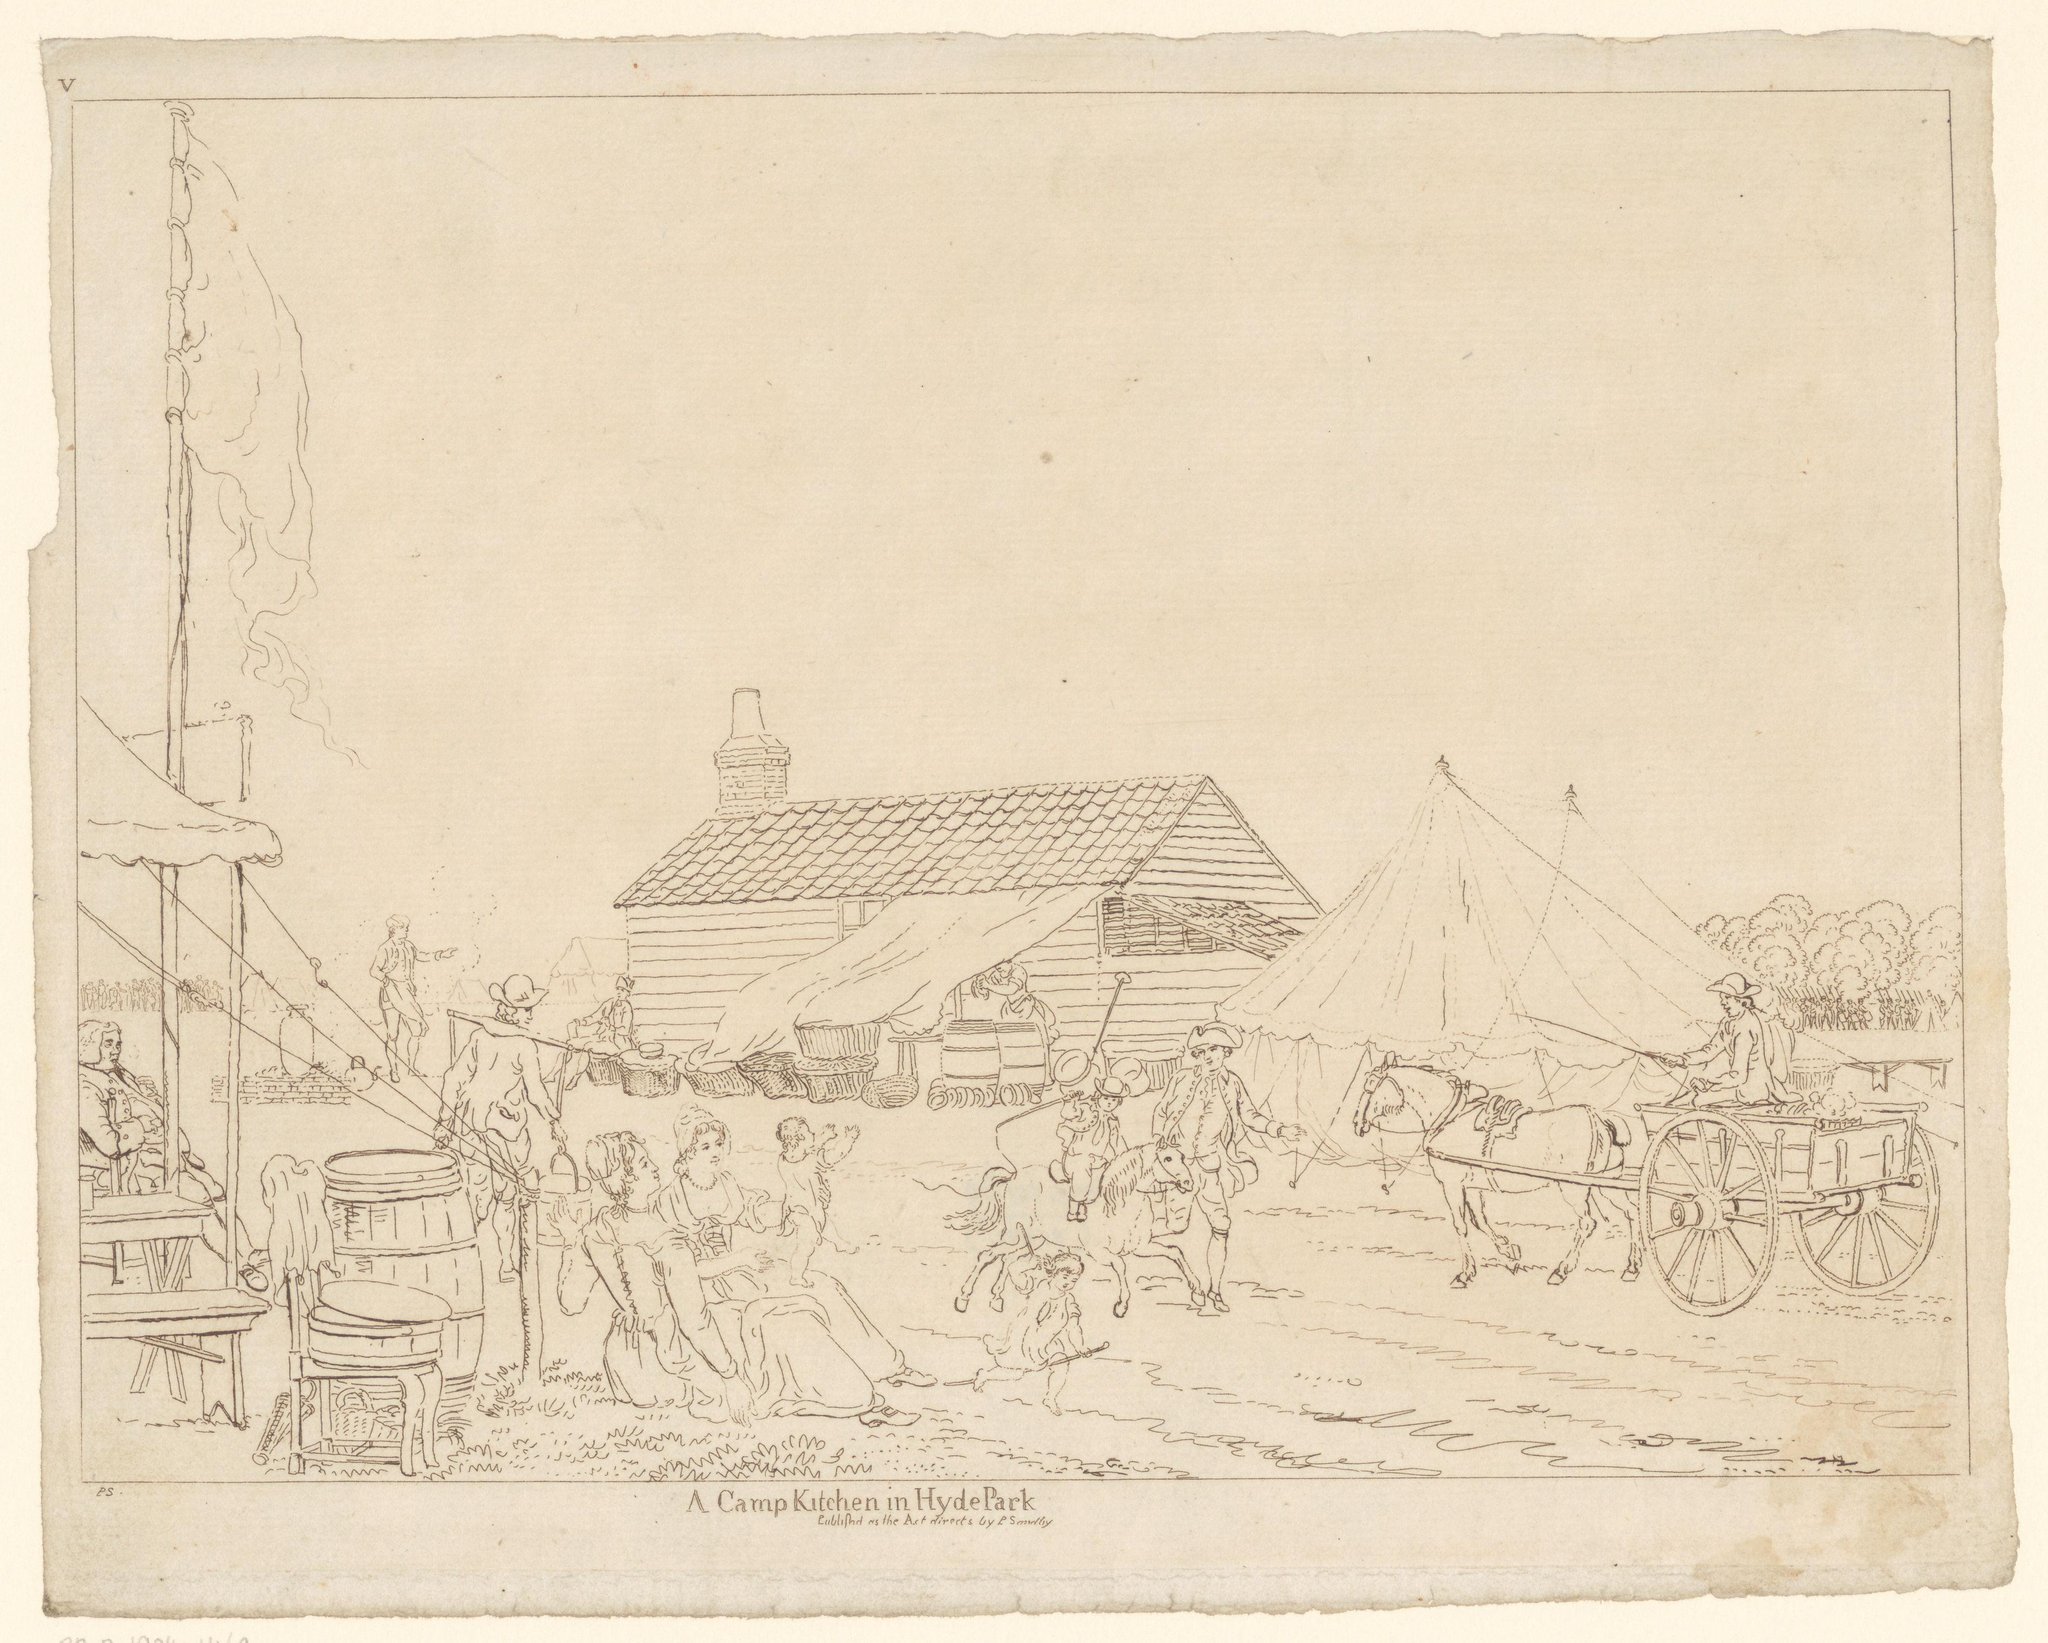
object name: print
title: Gezichten op militaire kampementen, tweede serie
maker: paul sandby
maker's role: draughtsman, print maker, publisher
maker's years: 1725-1809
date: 1780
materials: paper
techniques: etching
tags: (military) camp with tents, public gardens, park (+ city(-scape) with figures, staffage)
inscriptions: collector's mark: Lugt 2228